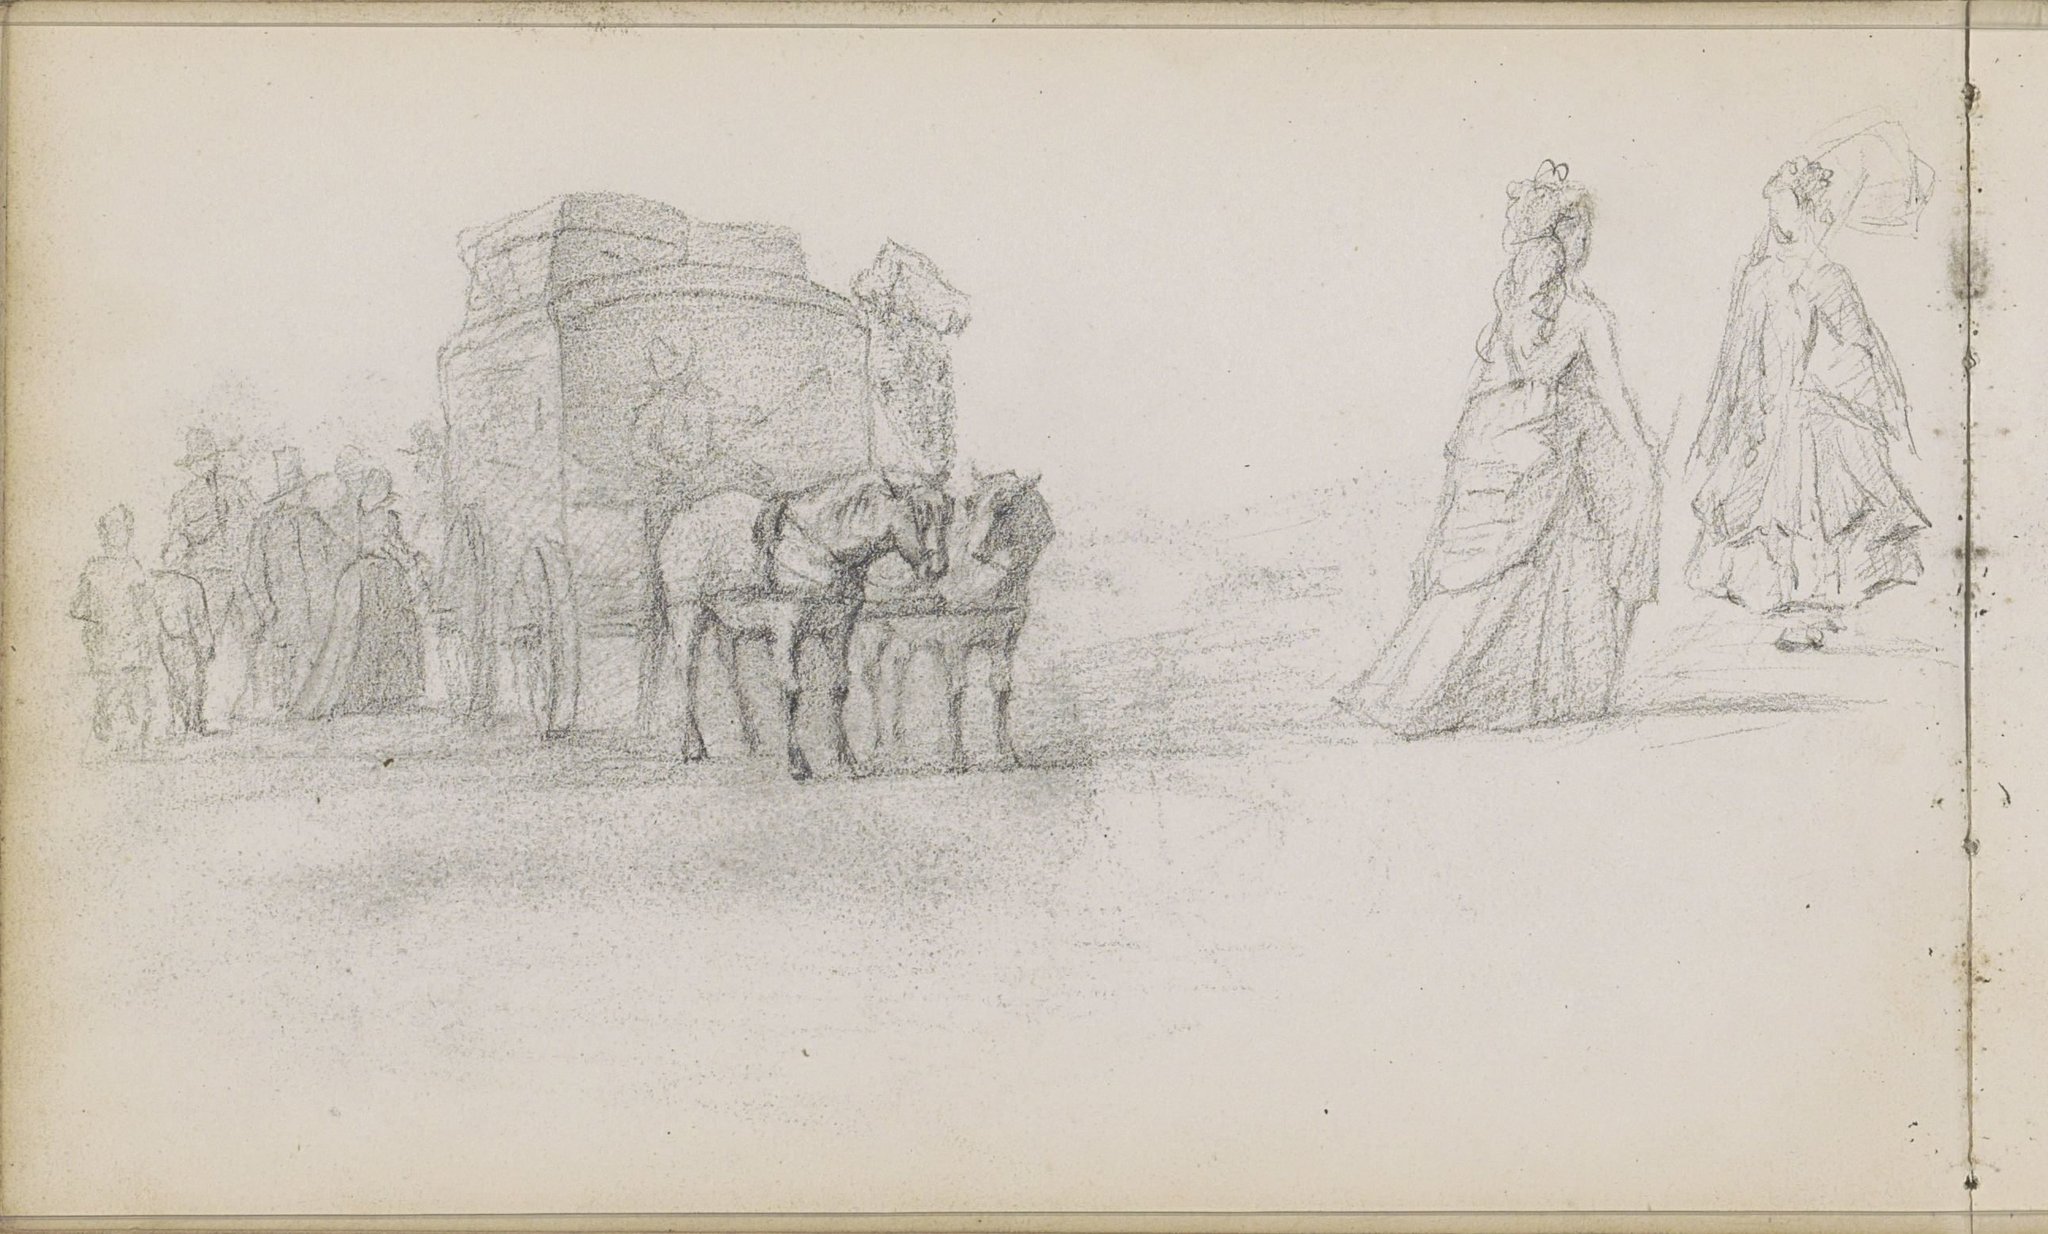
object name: sketchbook leaf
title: Paardenkoets en figuren op een straat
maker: willem cornelis rip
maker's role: draughtsman, painter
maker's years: 1856-1922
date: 1874-1875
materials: paper, pencil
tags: four-wheeled vehicle drawn by two animals, street (+ city(-scape) with figures, staffage)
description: Blad 12 verso uit een schetsboek met 46 bladen.